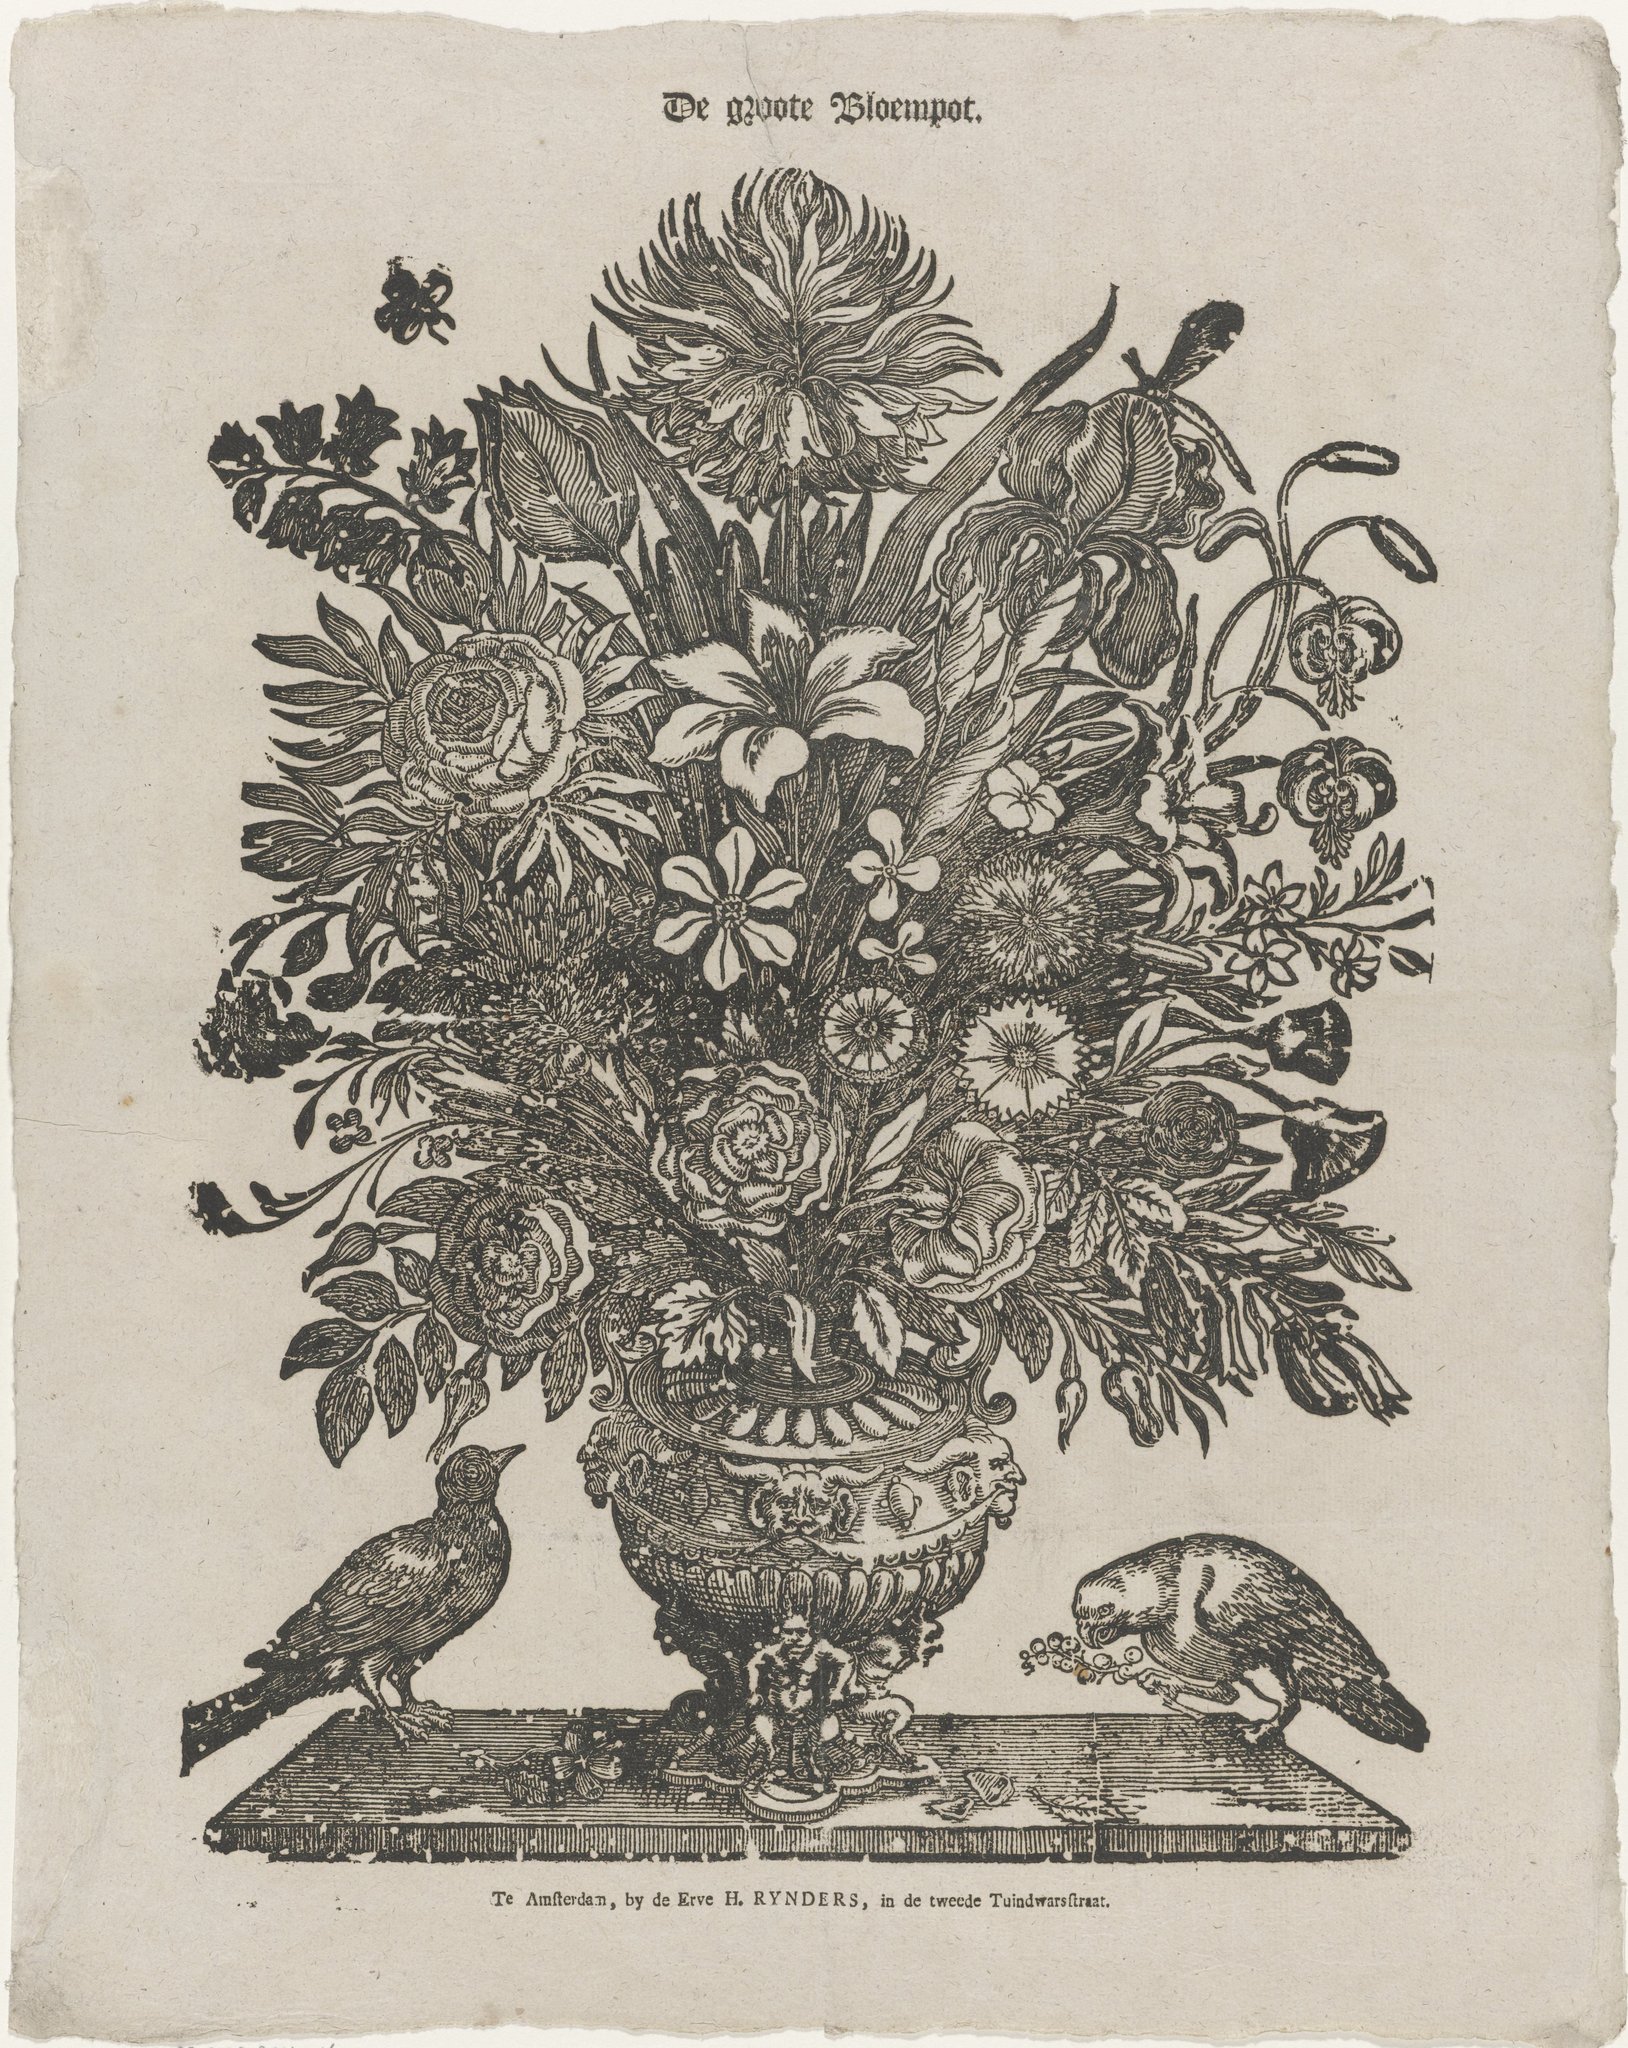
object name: print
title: De groote bloempot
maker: Anonymous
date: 1831-1854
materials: paper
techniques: letterpress printing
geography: amsterdam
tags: flowers, birds, flowers in a vase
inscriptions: collector's mark: Lugt 2760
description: Blad met een grote voorstelling van een vaas met een bos van verschillende bloemen. Naast de vaas twee vogels, waaronder een papegaai.